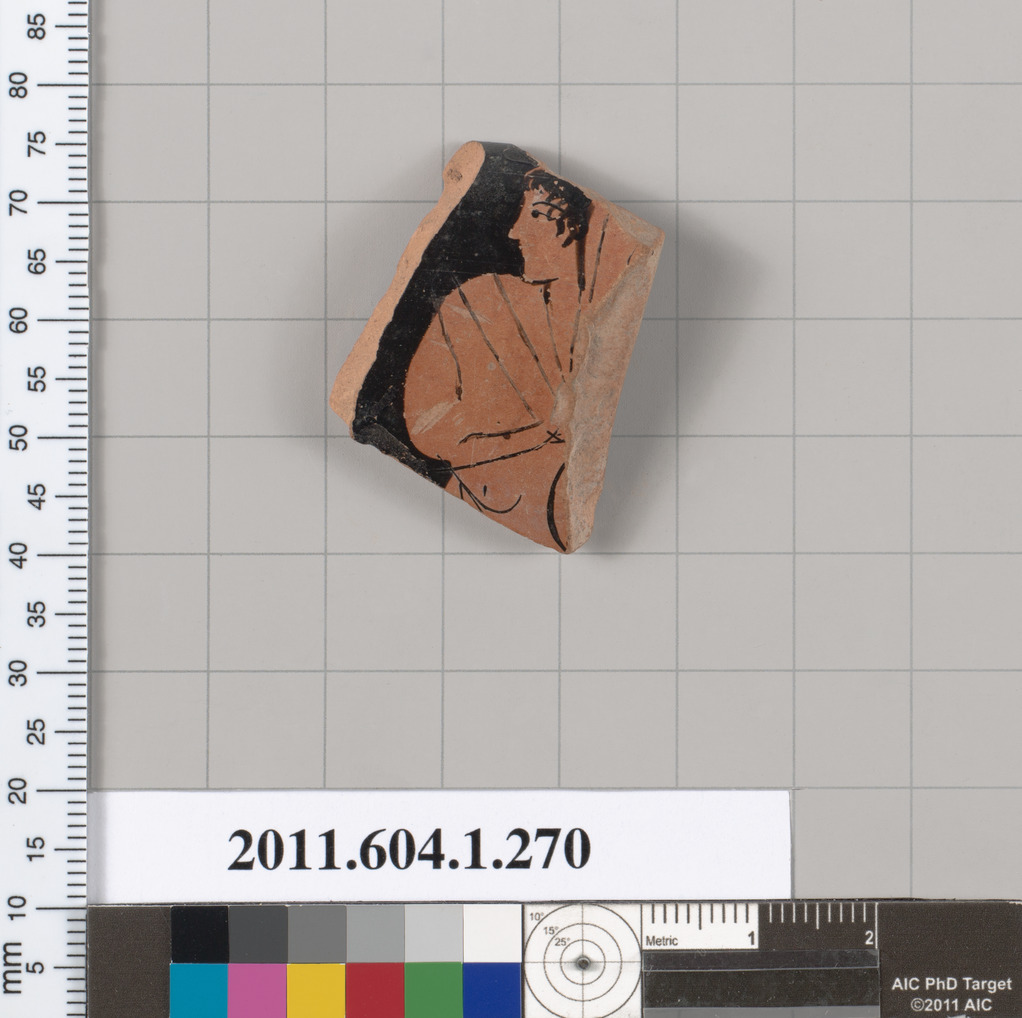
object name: kylix fragment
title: Terracotta rim fragment of a kylix (drinking cup)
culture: greek, attic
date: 475-451 BCE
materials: terracotta